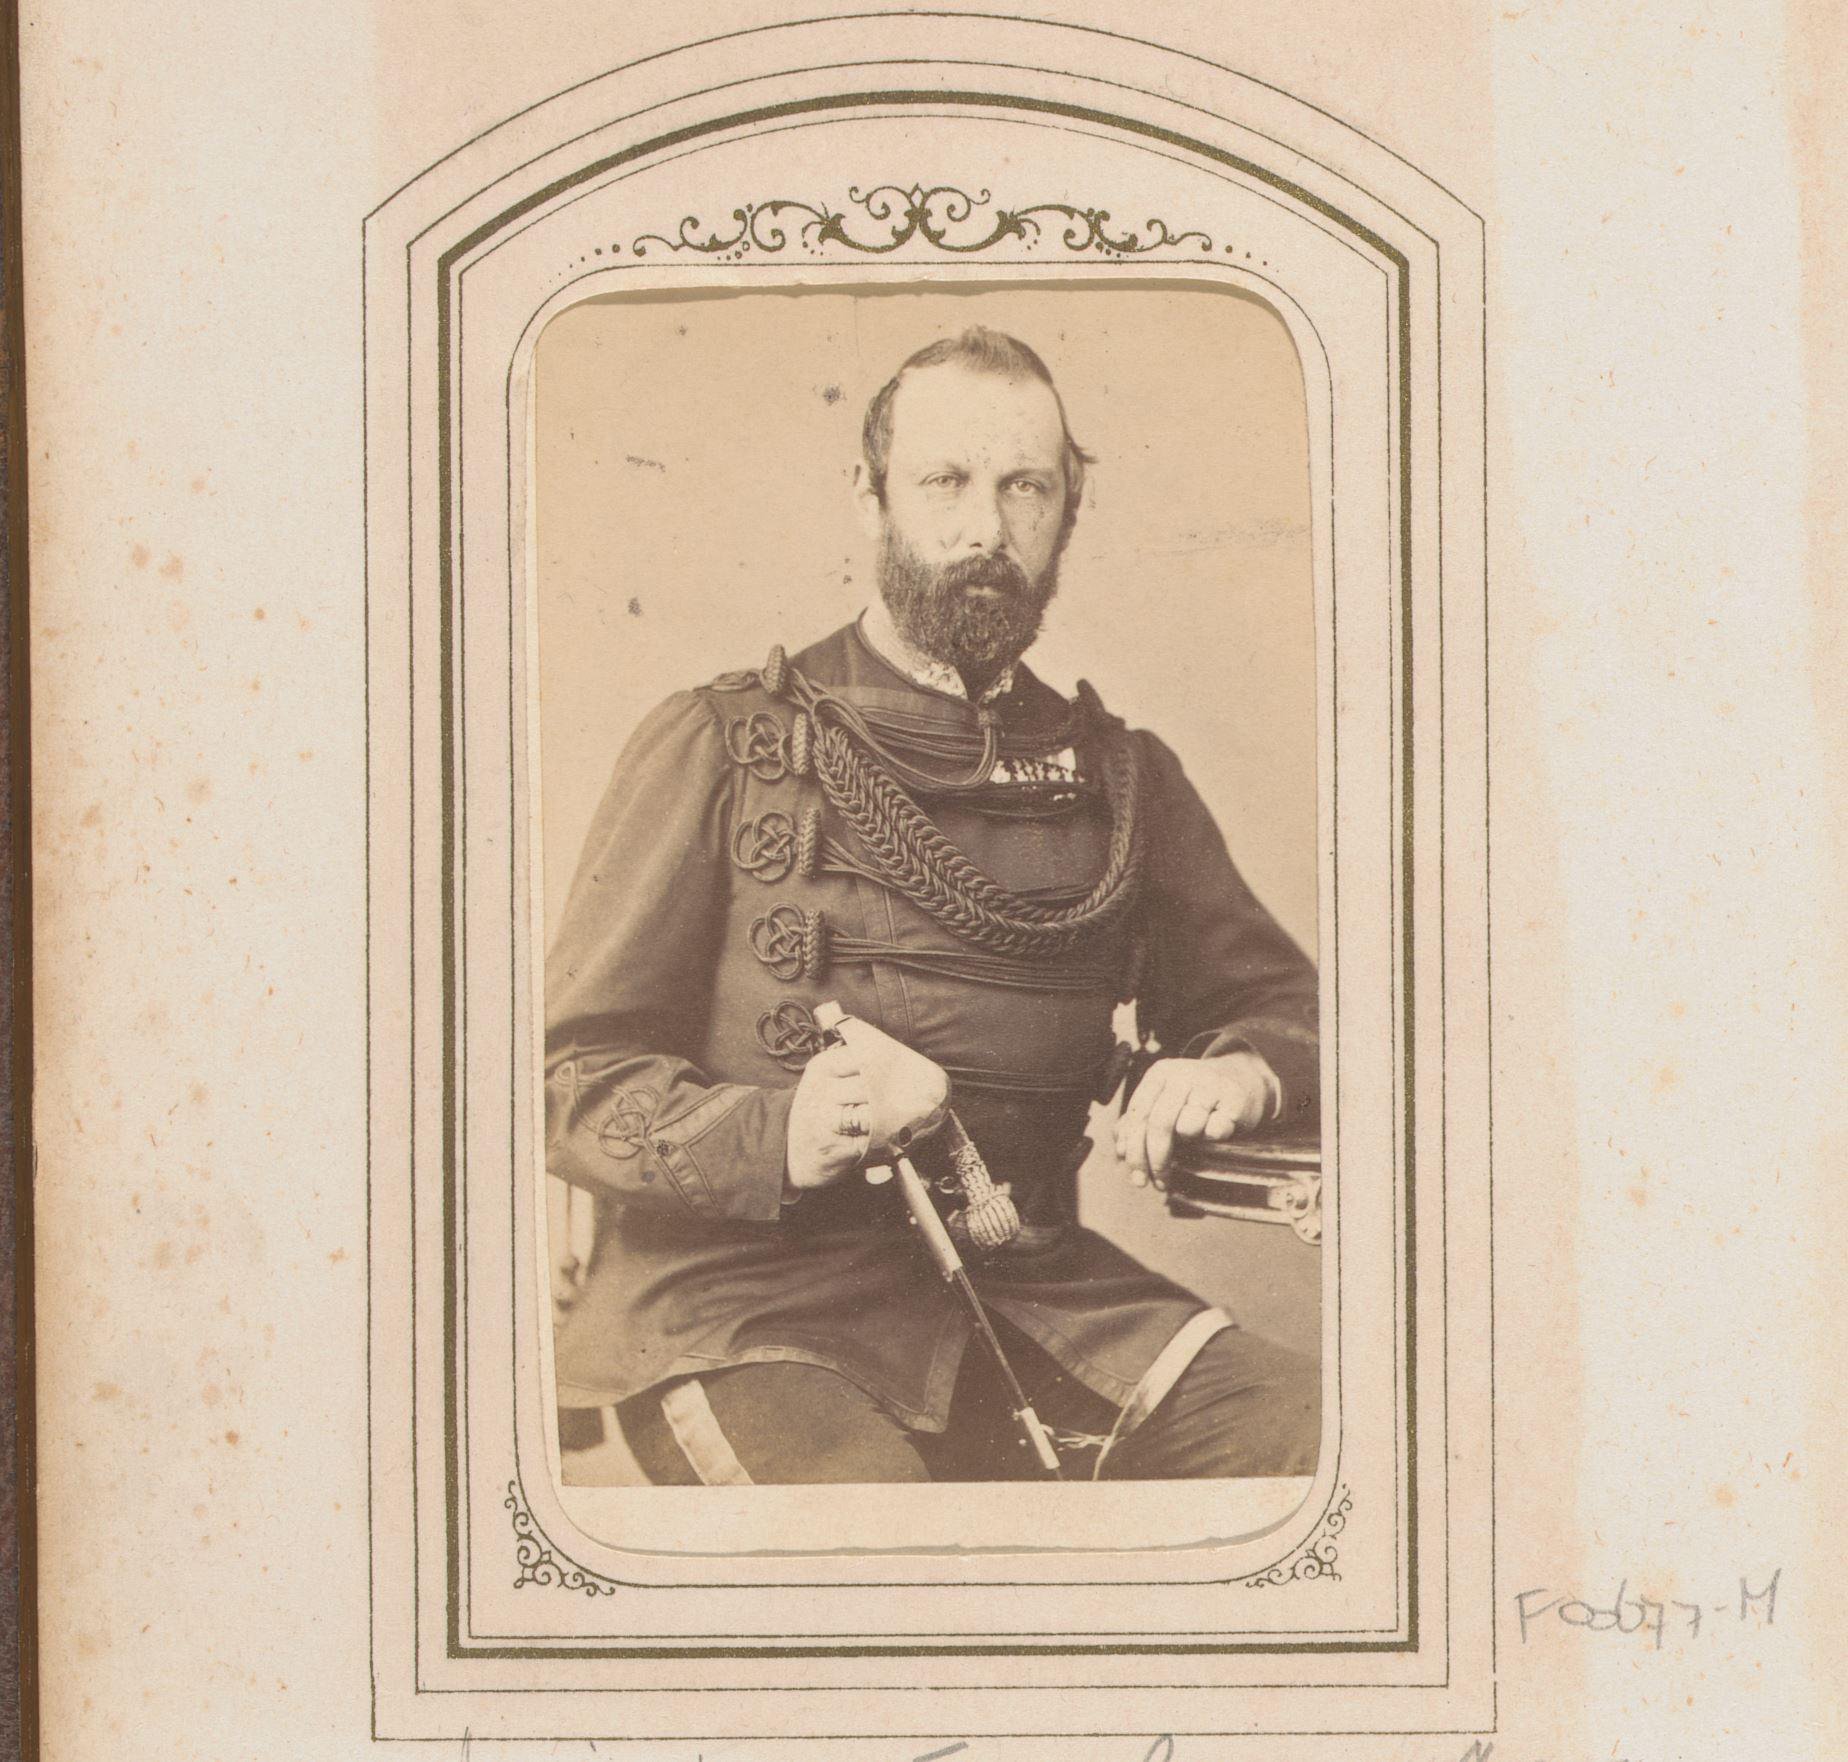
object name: album leaf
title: Portret van Karel XV, koning van Zweden en Noorwegen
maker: math. hansen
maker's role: fotograaf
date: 1860-1875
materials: cardboard, photographic support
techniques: albumen print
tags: karel xv (koning van zweden en noorwegen), historical persons, king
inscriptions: annotation: ‘koning Karl XV van Zweden en Noorwegen/ geb 1826 overl 1872’, annotation: ‘Köning v Schweden.’, inscription: ‘MATHs HANSEN/ KONGL. HOF-PHOTOGRAF/ Drottninggatan No 5/ STOCKHOLM’